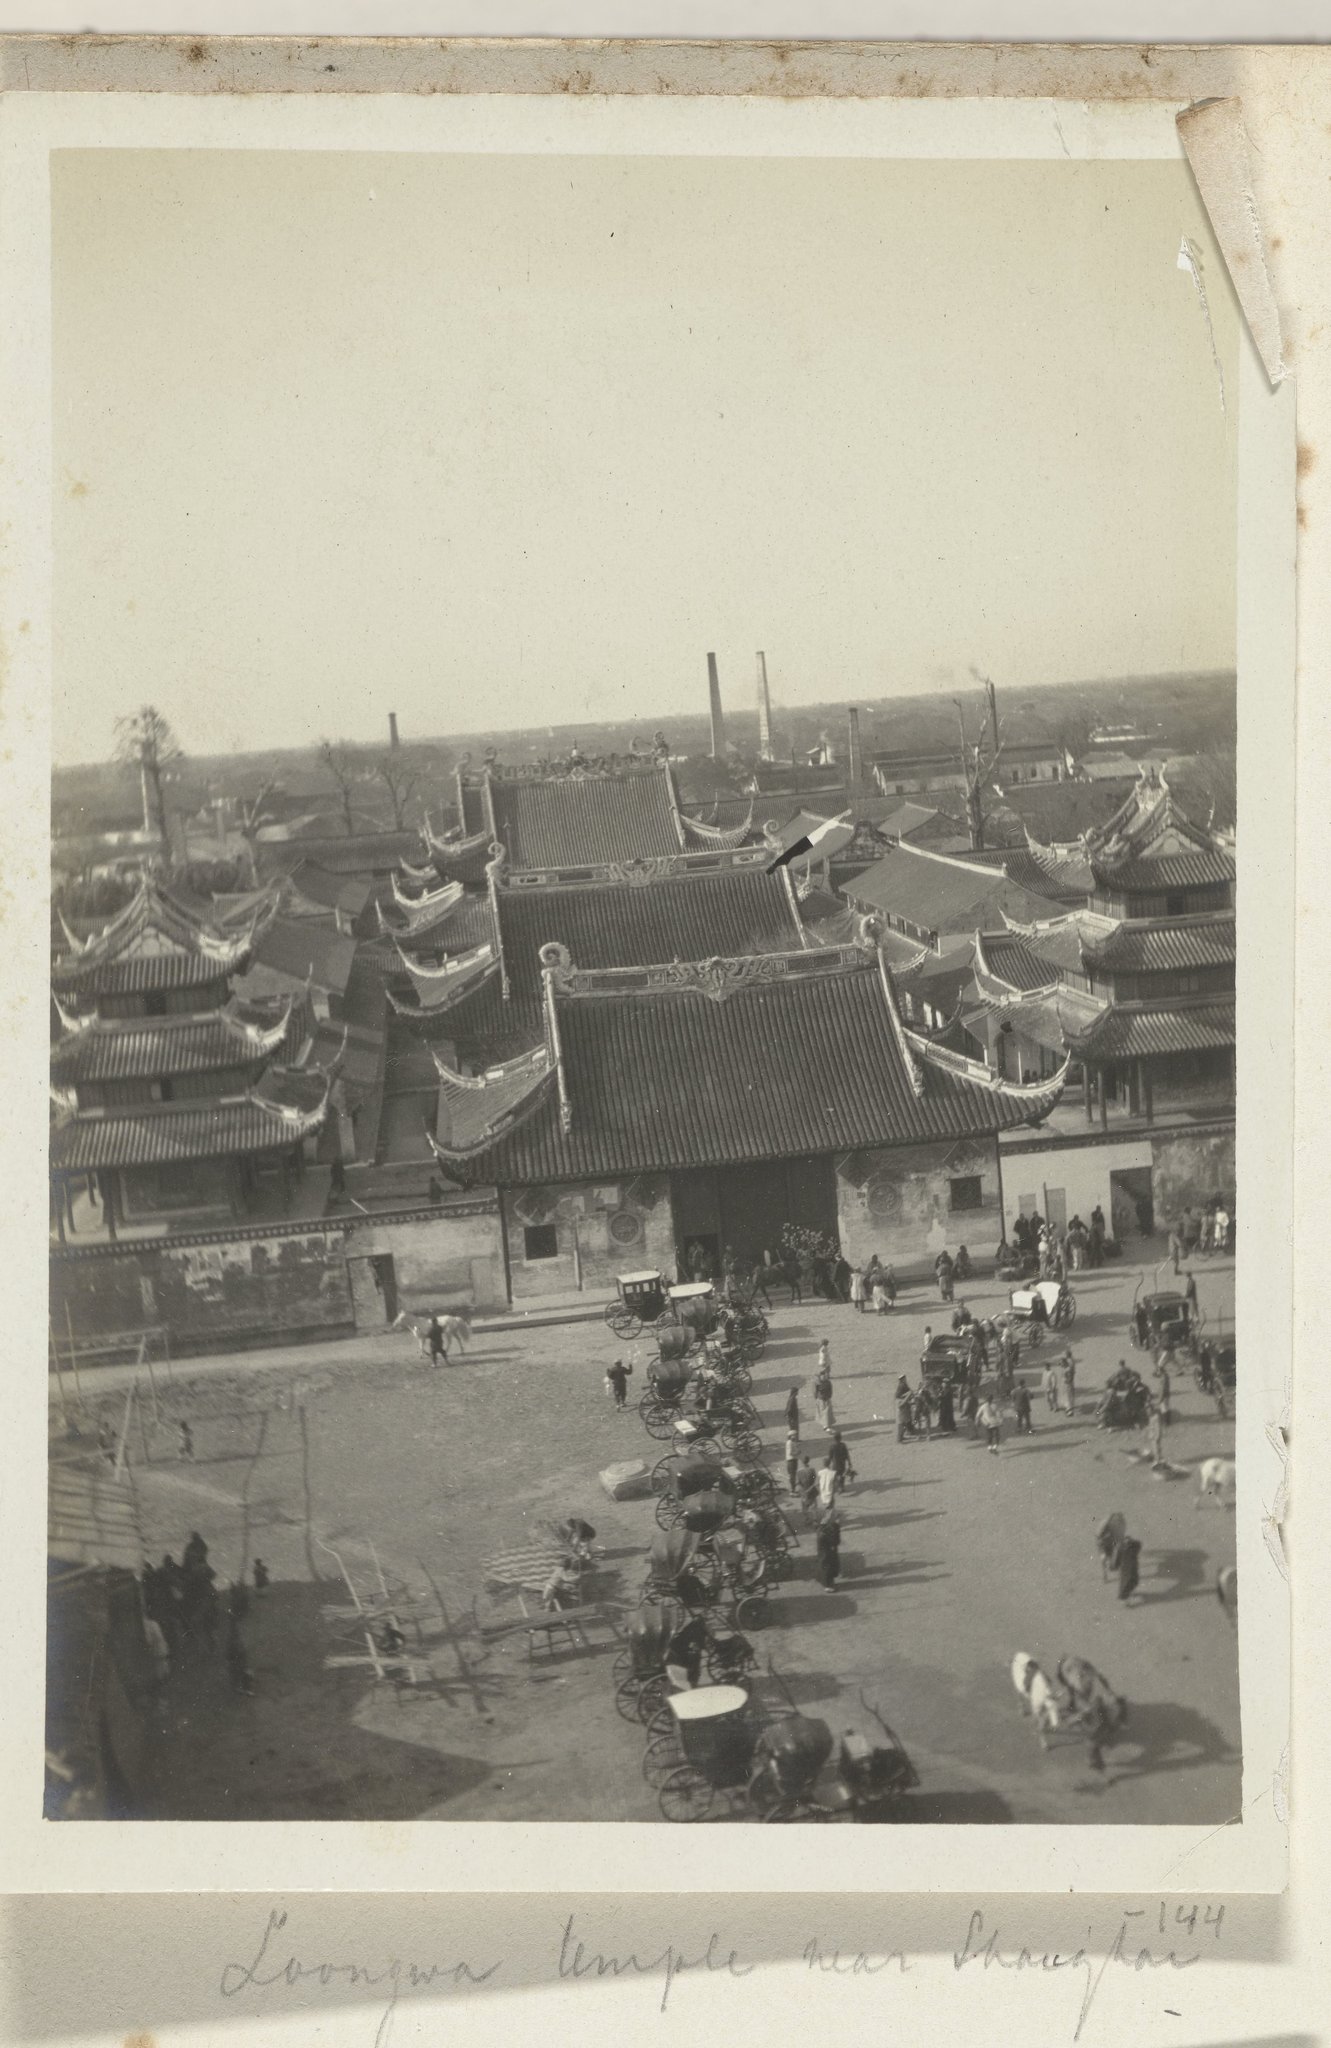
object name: photograph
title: Loongwa temple near Shanghai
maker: geldolph adriaan kessler (dolph)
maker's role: fotograaf, industrieel, voetballer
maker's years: 1884-1945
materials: cardboard, photographic support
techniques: gelatin silver print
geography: shanghai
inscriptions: title: ‘Loongwa temple near Shanghai’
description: Bovenaanzicht van het Boeddhistische tempelcomplex Longhua in Shanghai. Onderdeel van het fotoalbum van Dolph Kessler met opnamen die hij maakte tijdens zijn verblijf in Engeland en op een wereldreis die hij als secretaris van Henri Deterding (directeur Koninklijke Olie) ondernam naar Nederlands-Indië, Japan, China en de Verenigde Staten, tussen 1906 en 1908.